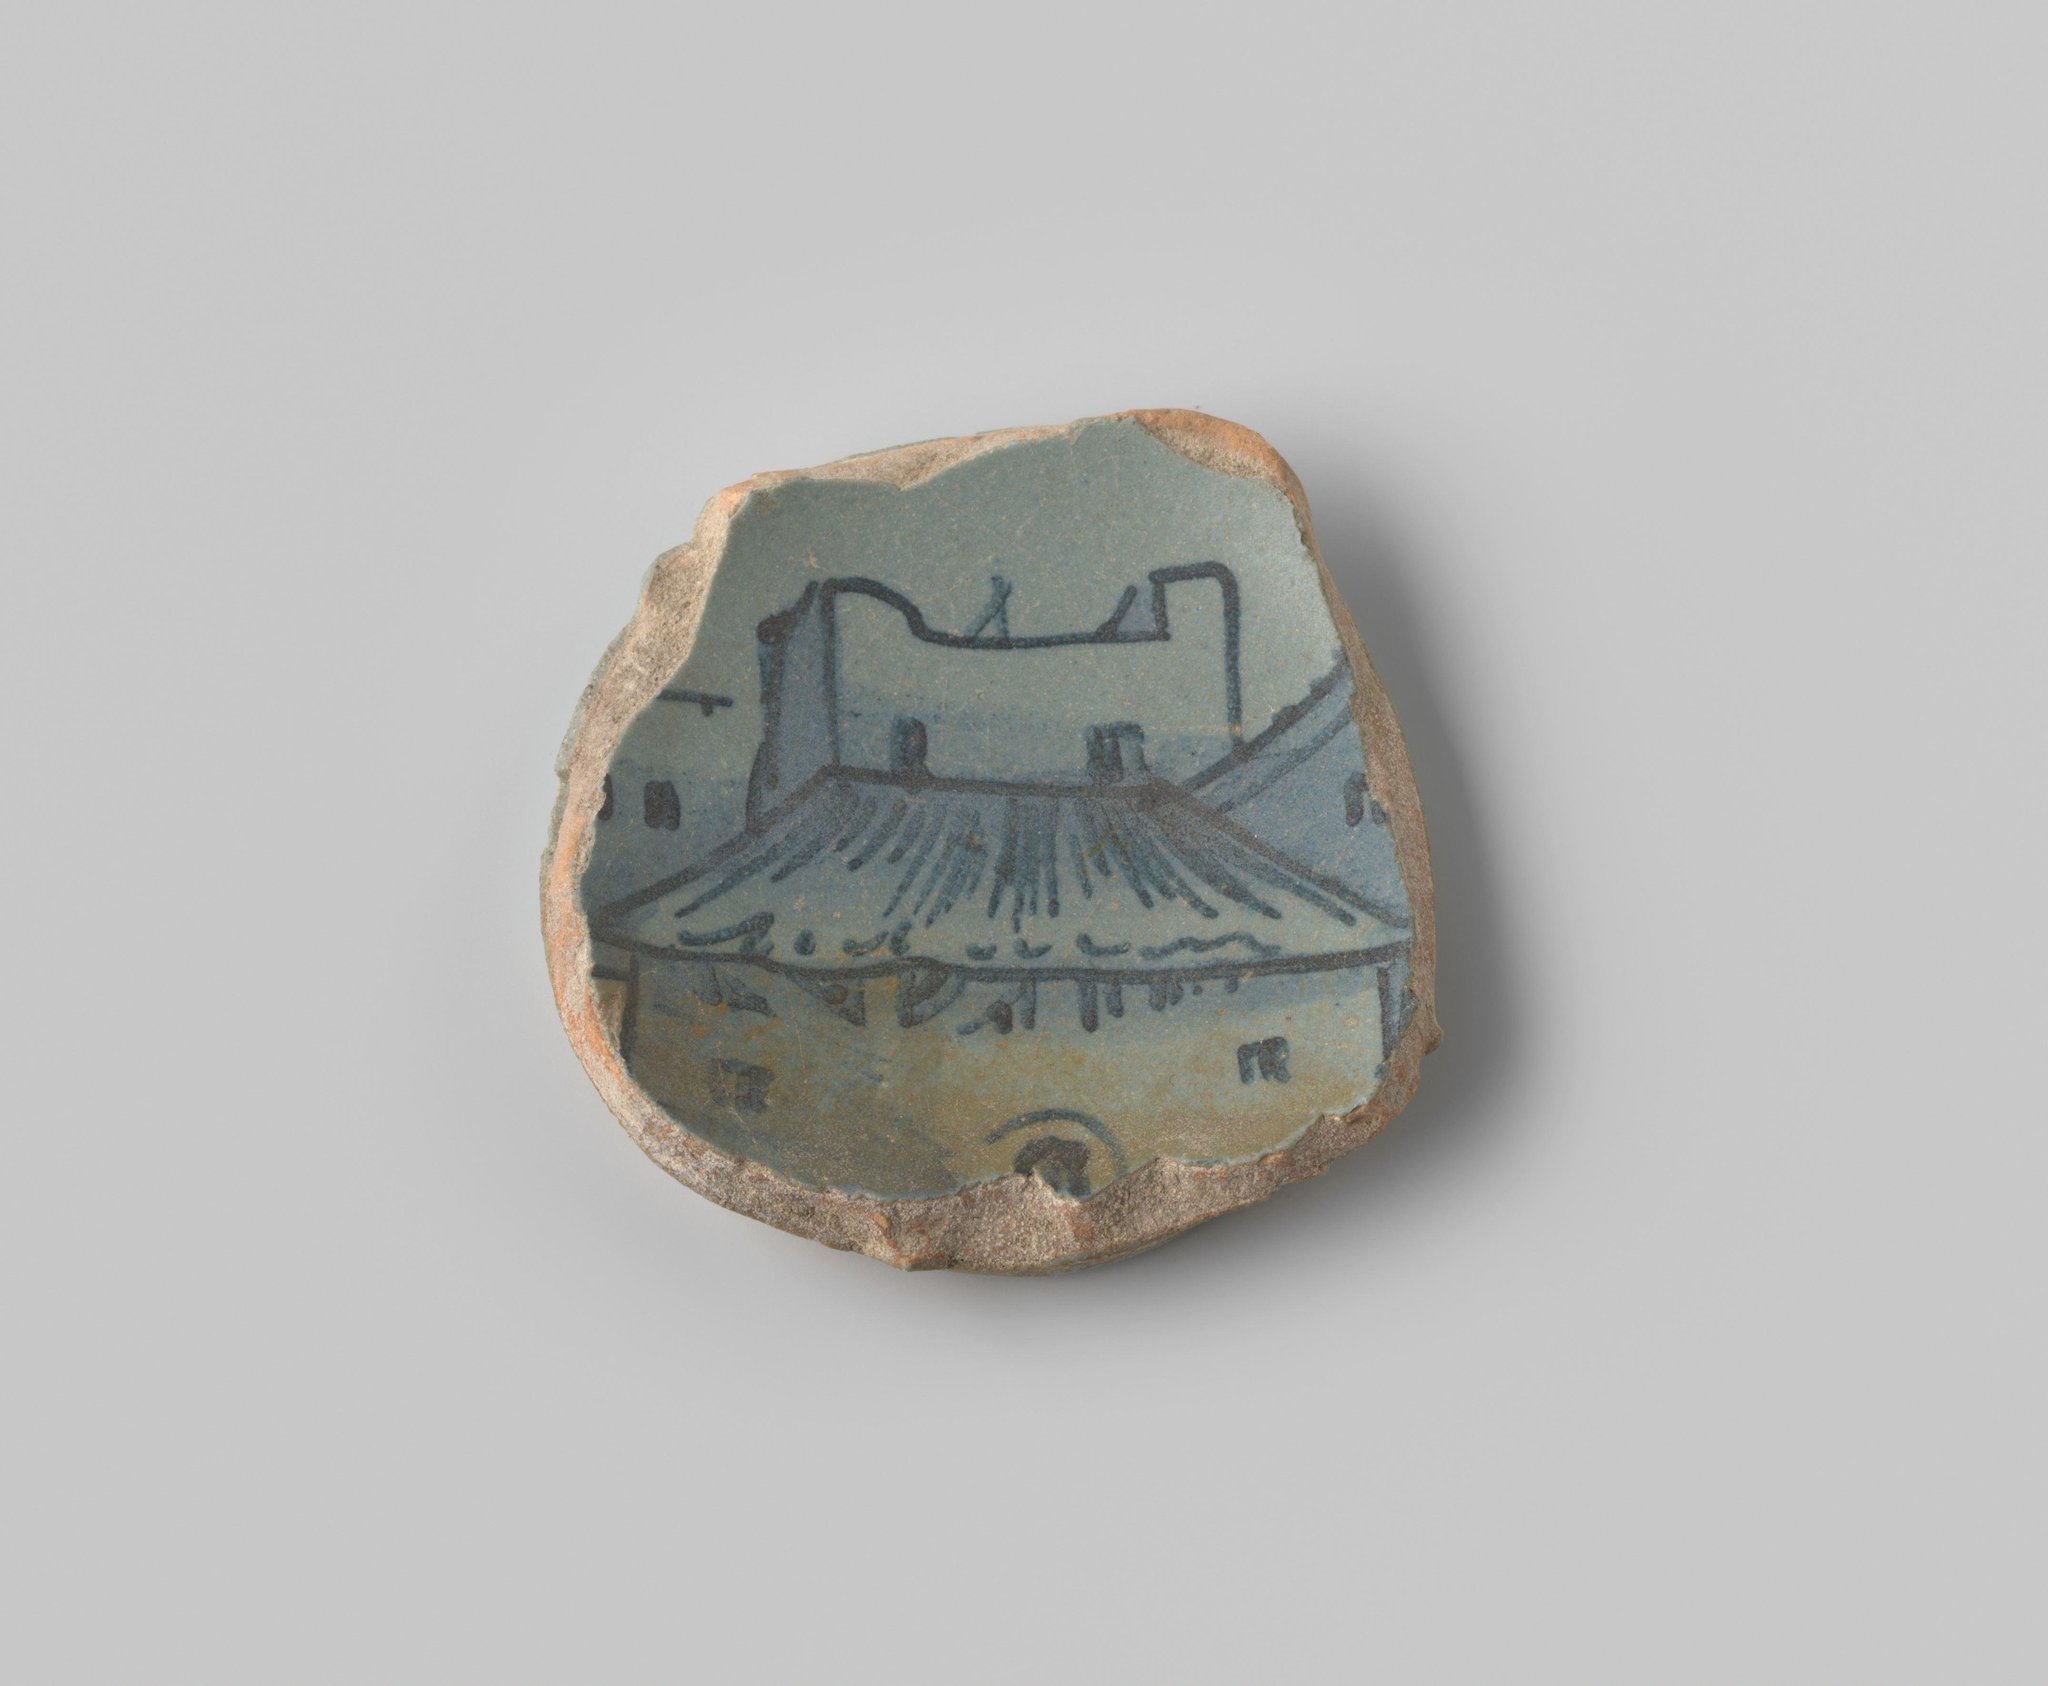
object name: sherd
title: Fragment (voet) met zachtroze scherf, in gedekt blauw glazuur een gebouw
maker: Anonymous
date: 1200-1899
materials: earthenware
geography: italy